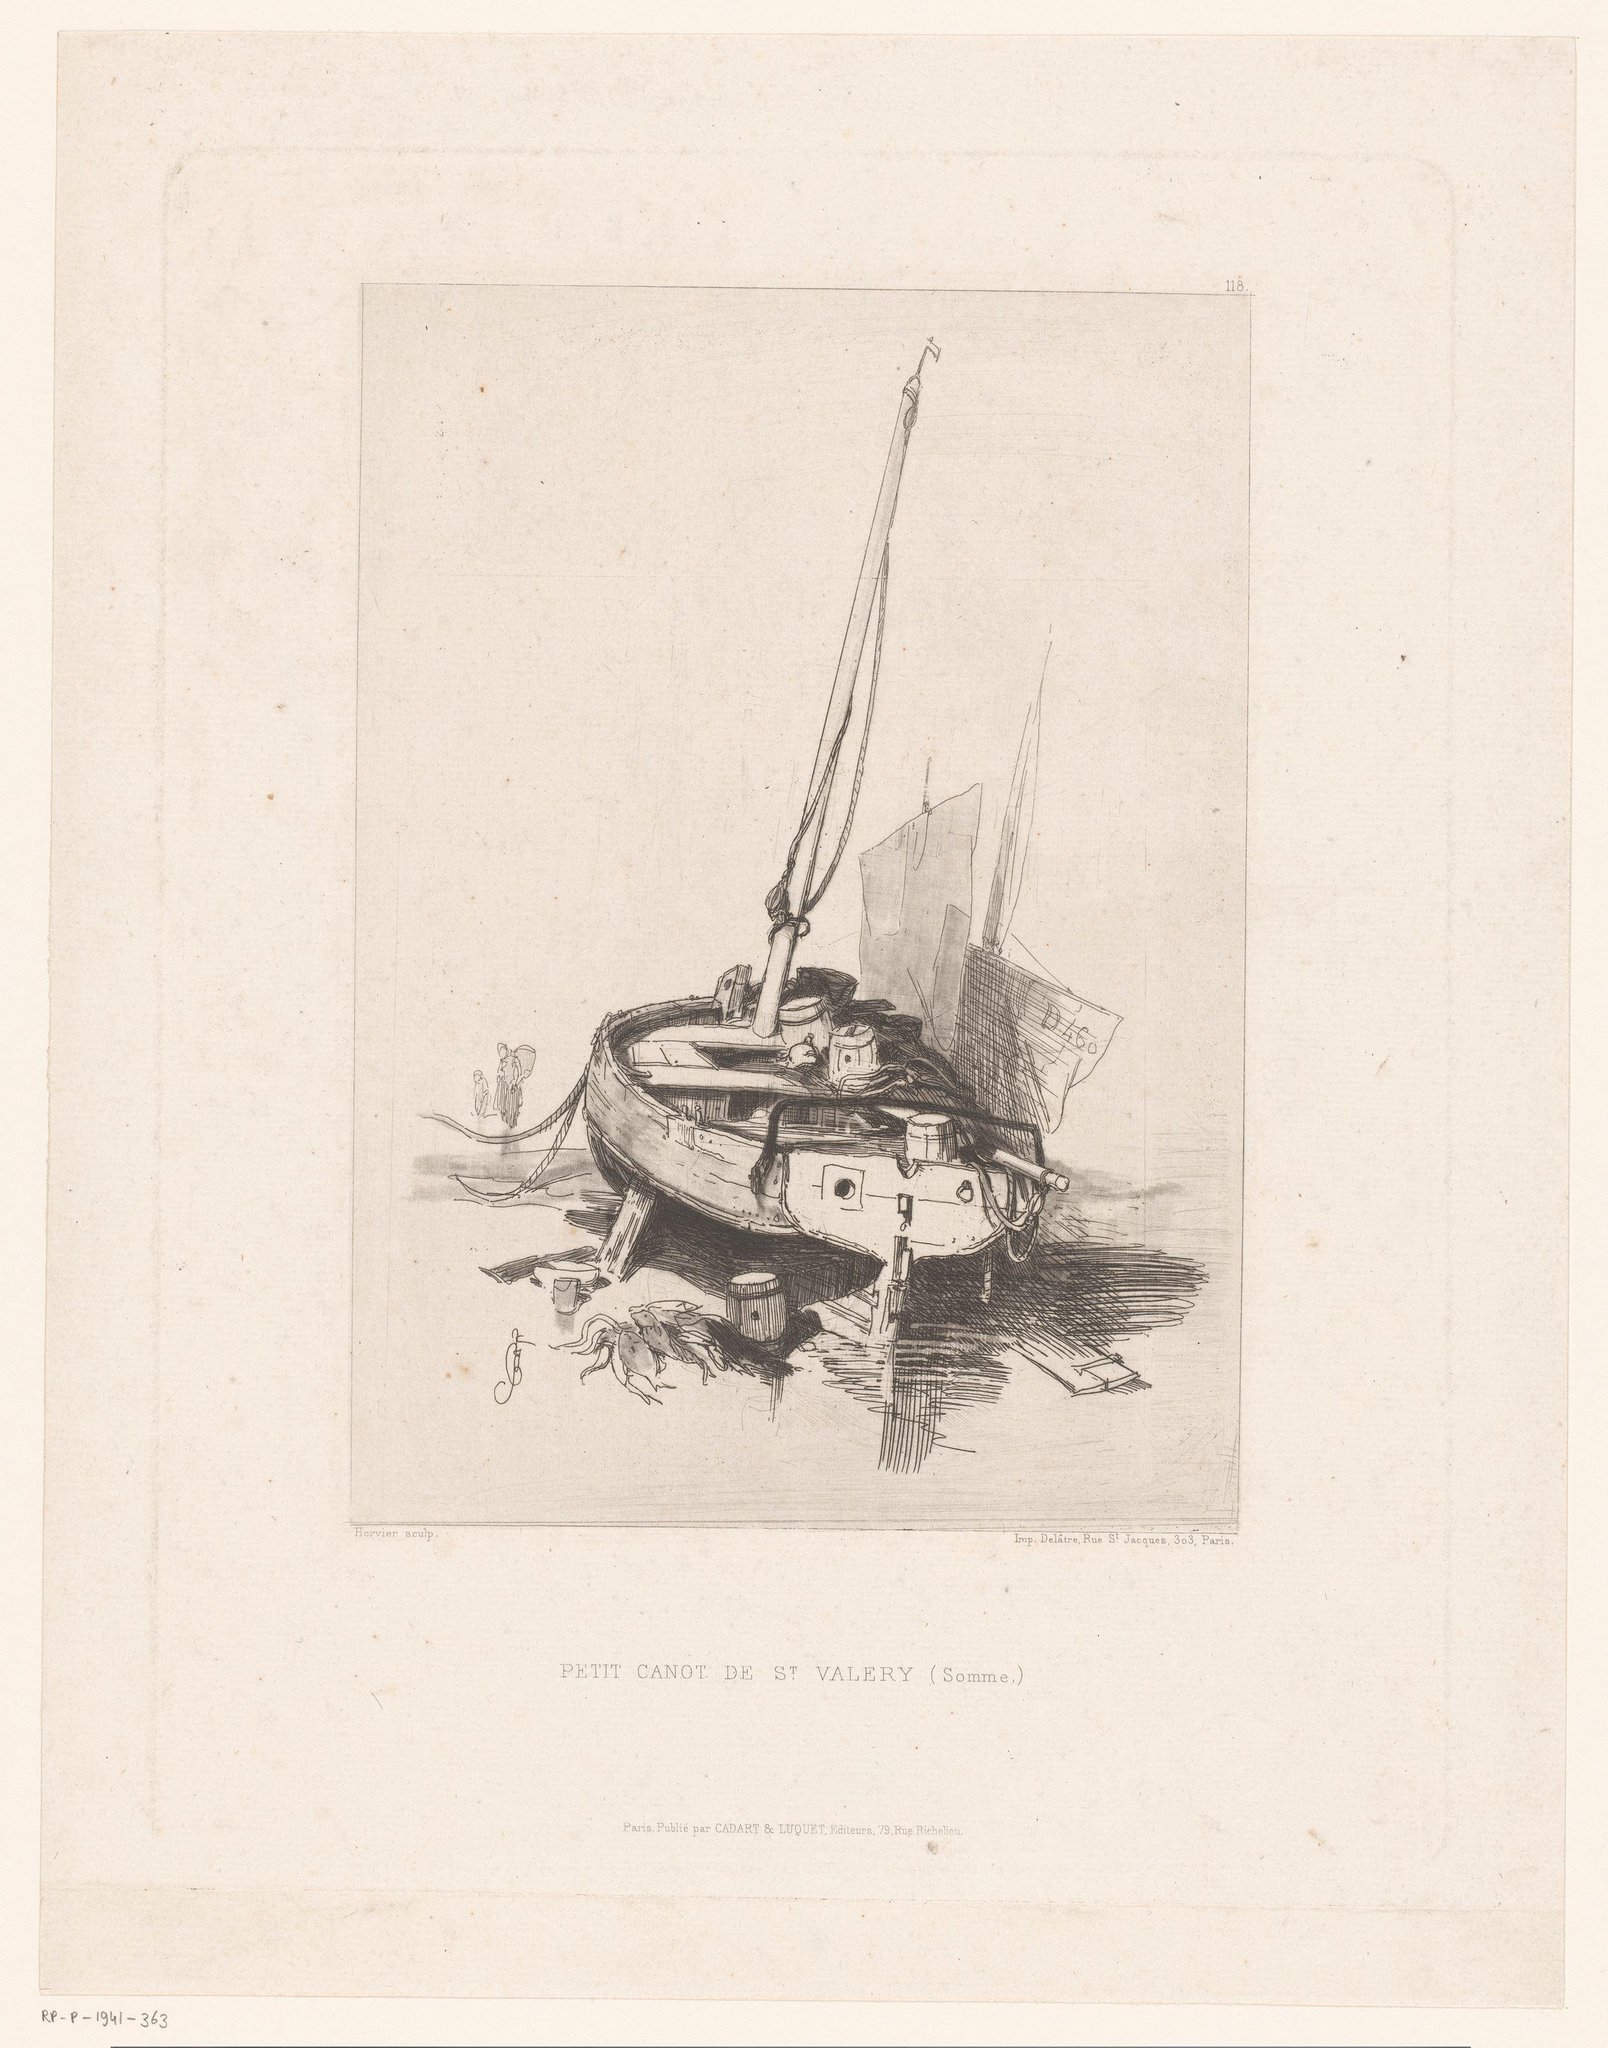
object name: print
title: Petit canot de St. Valery (Somme.)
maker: louis-adolphe hervier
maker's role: draughtsman, painter, print maker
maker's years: 1818-1879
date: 1864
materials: paper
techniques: etching, intaglio, roulette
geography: paris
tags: sailing-ship, sailing-boat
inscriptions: collector's mark: Lugt 2228, collector's mark: Lugt 2760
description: Gepubliceerd in 'Société des Aquafortistes', dl. 2, 1 augustus 1864.